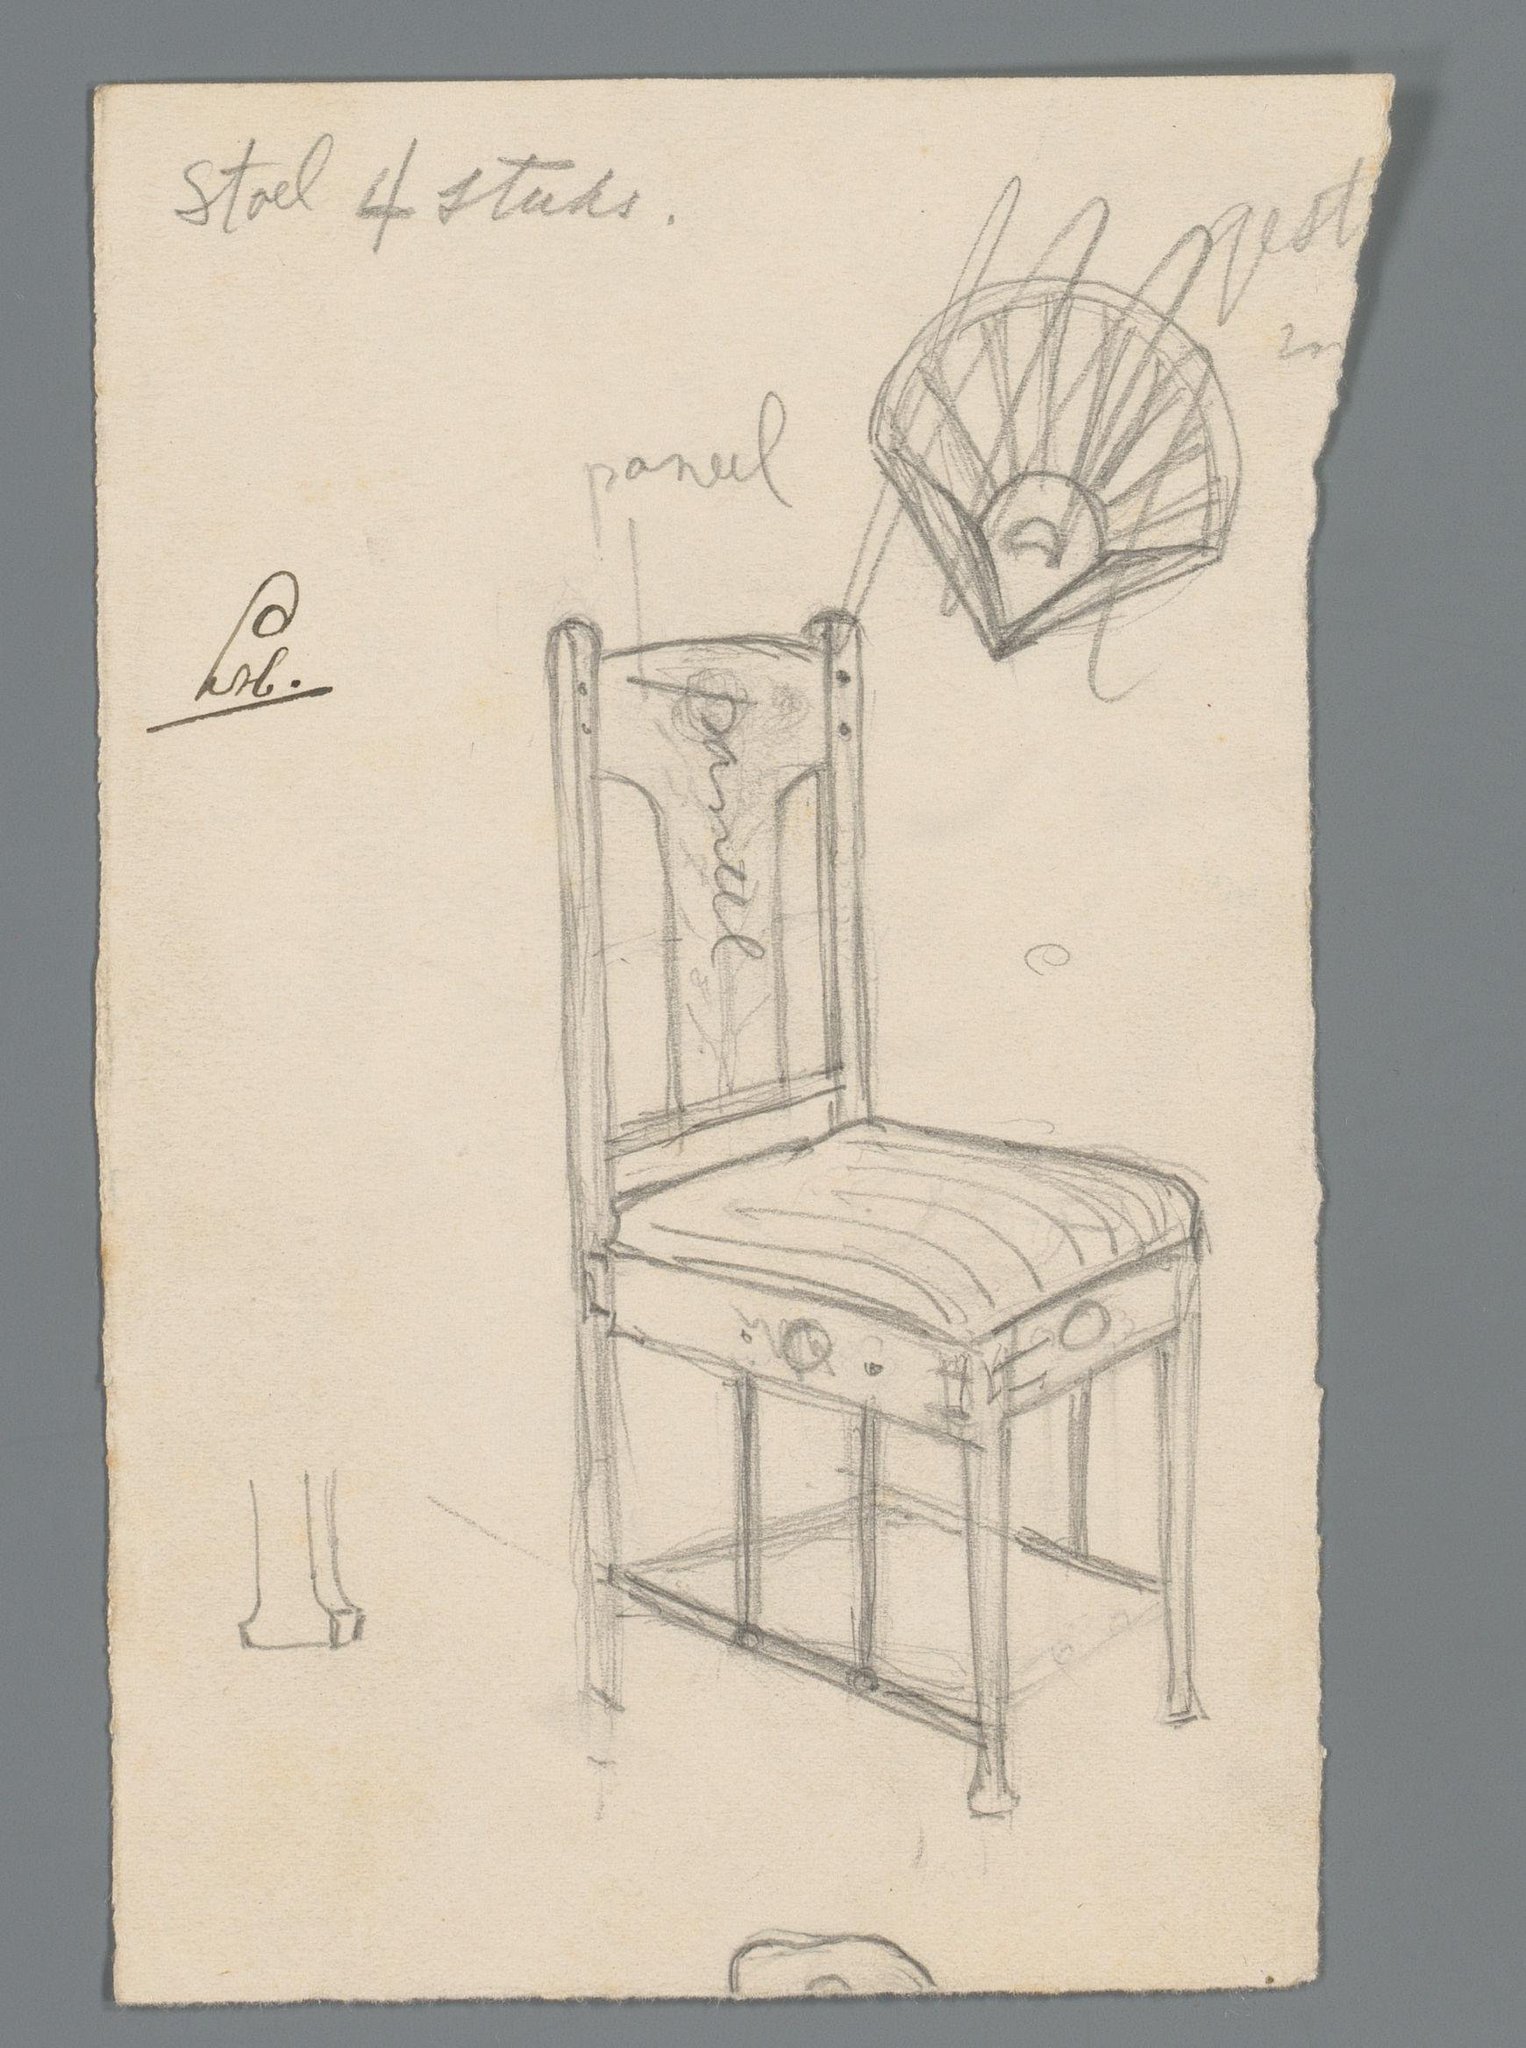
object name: design drawing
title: Ontwerp voor een stoel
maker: gust van de wall perné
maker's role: draughtsman, painter, print maker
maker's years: 1877-1911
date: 1887-1911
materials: paper, pencil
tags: chair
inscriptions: collector's mark: Lugt 2228